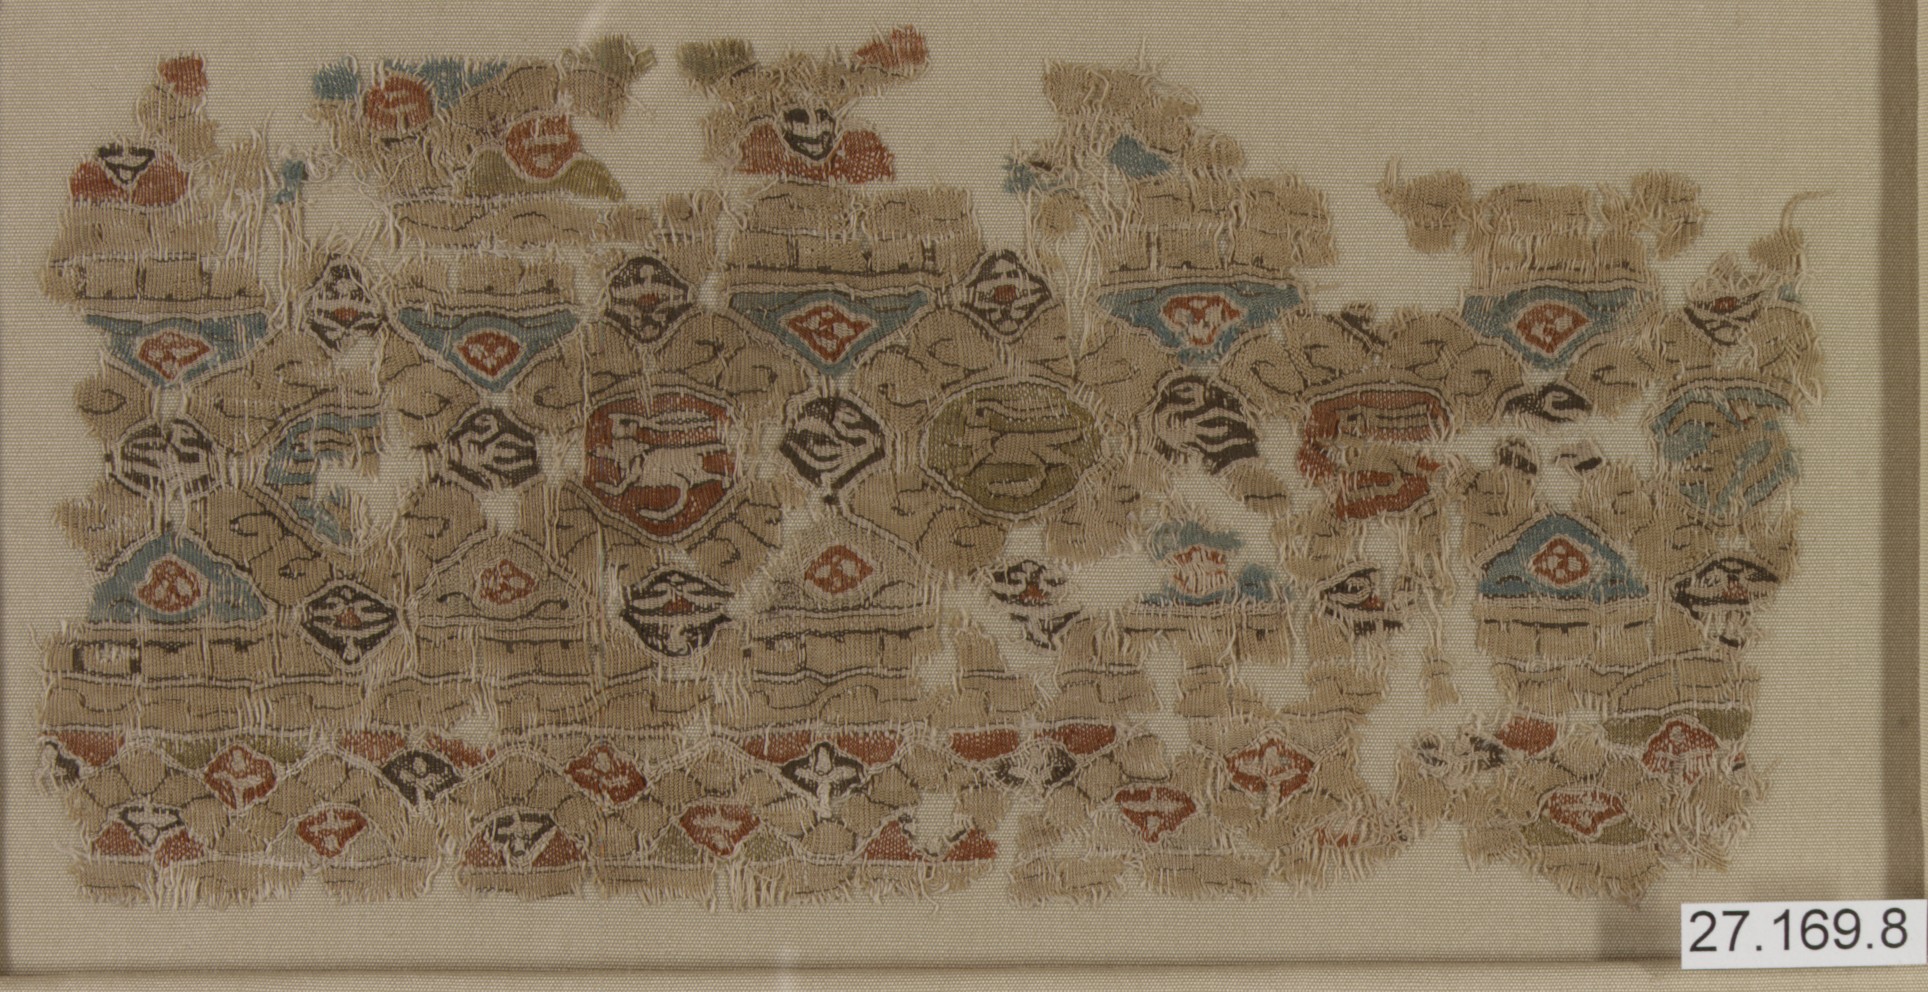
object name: band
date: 1001-1100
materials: linen, silk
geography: egypt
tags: animals